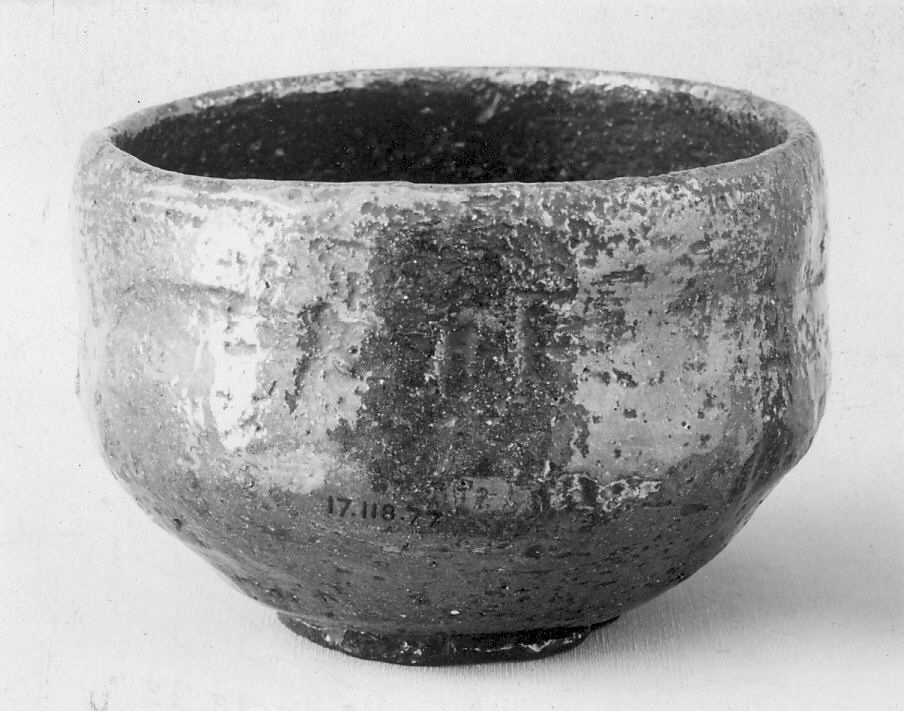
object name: teabowl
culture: japanese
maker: raku donyu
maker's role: artist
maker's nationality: japanese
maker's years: 1556-1656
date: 1650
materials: clay, glaze